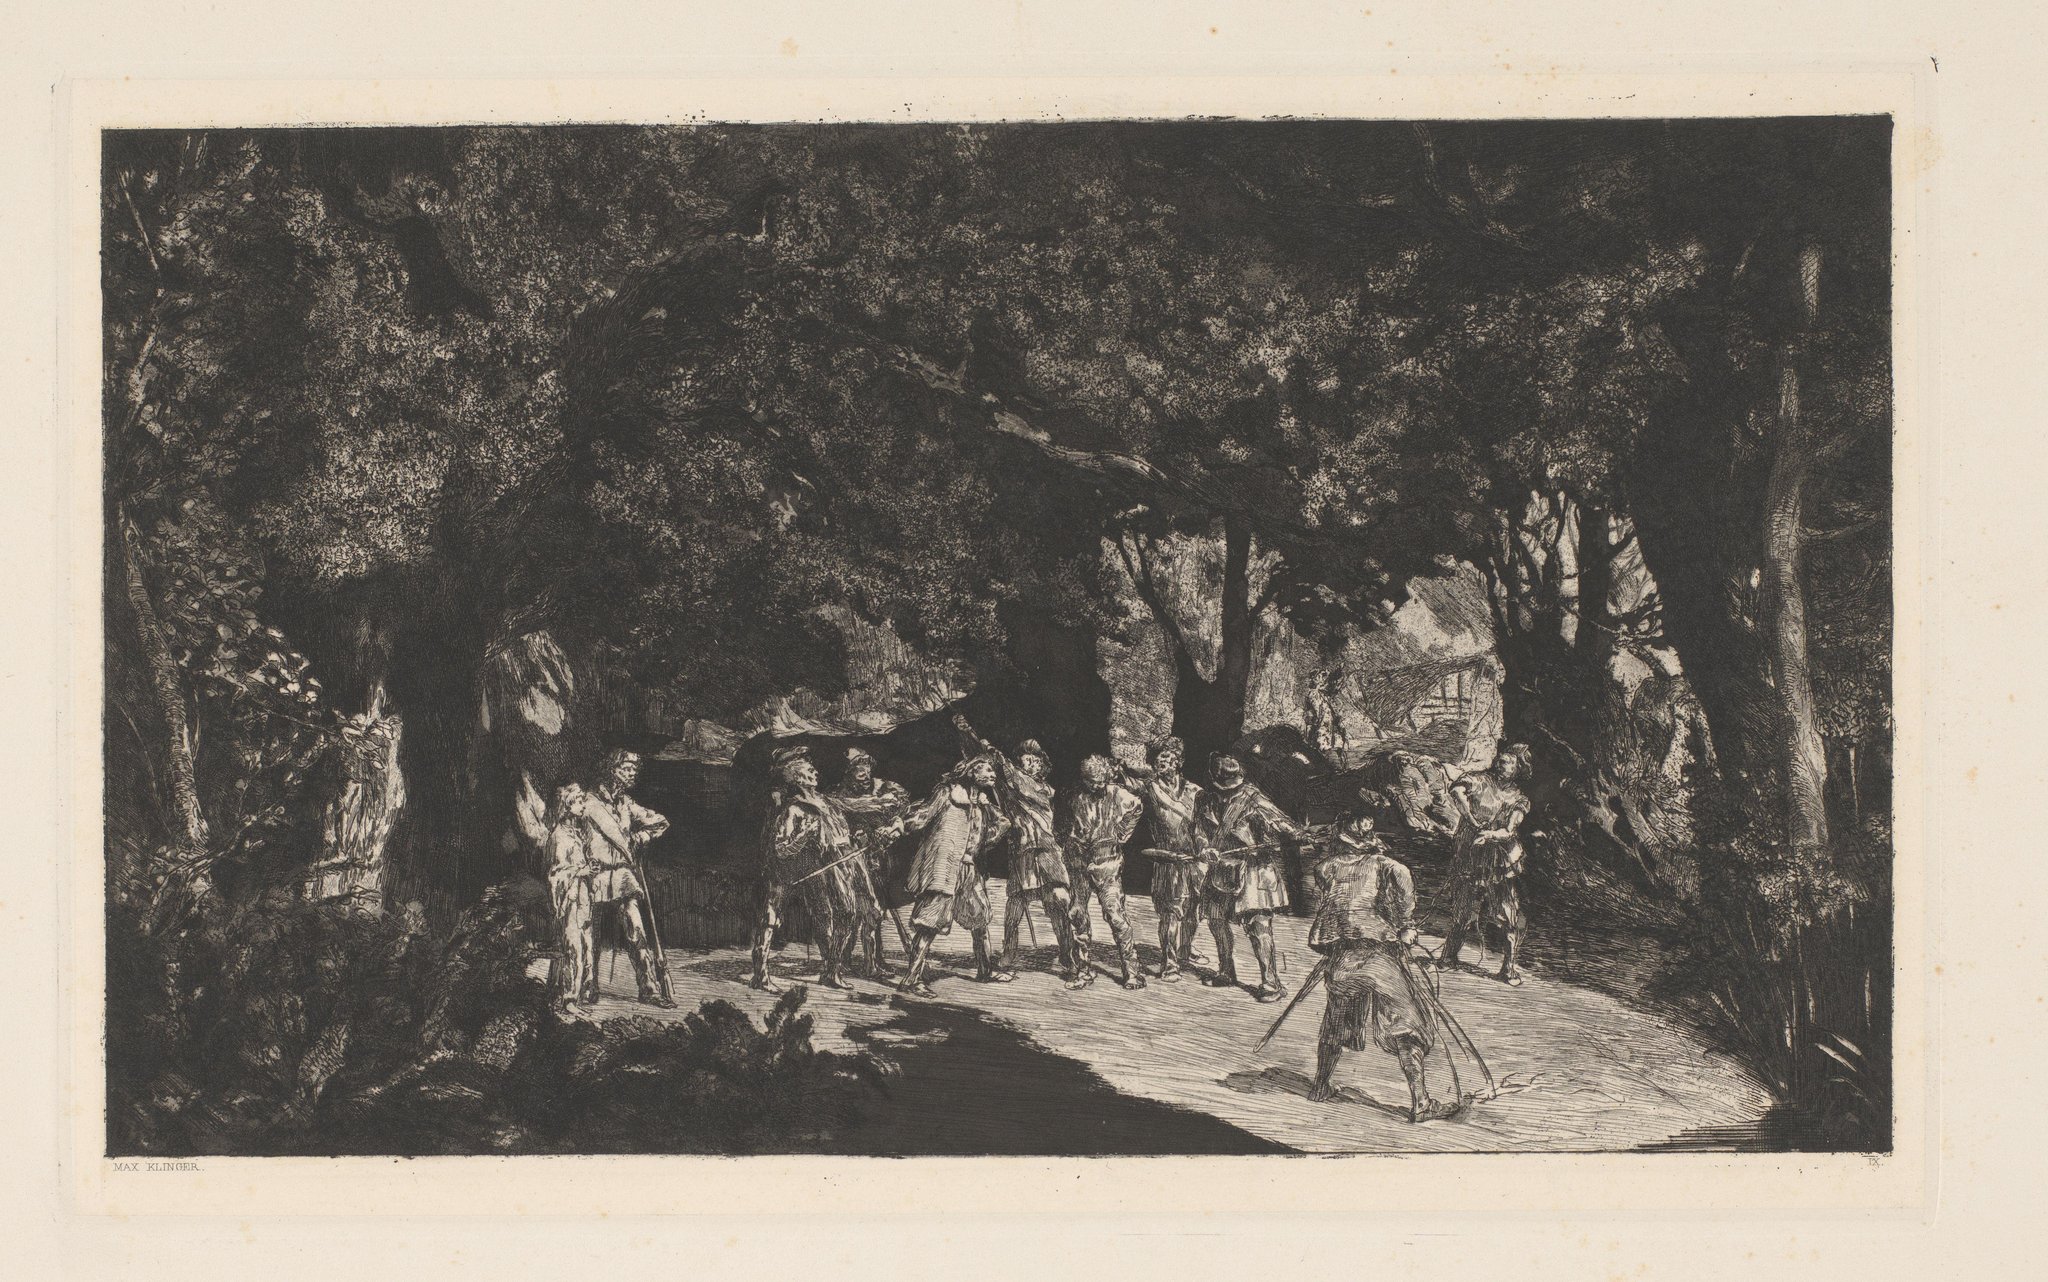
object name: print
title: Simplicius met een groep soldaten in een donker bos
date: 1881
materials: paper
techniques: aquatint, etching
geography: nuremberg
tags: forest, wood, the soldier; the soldier's life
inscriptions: collector's mark: Lugt 2228